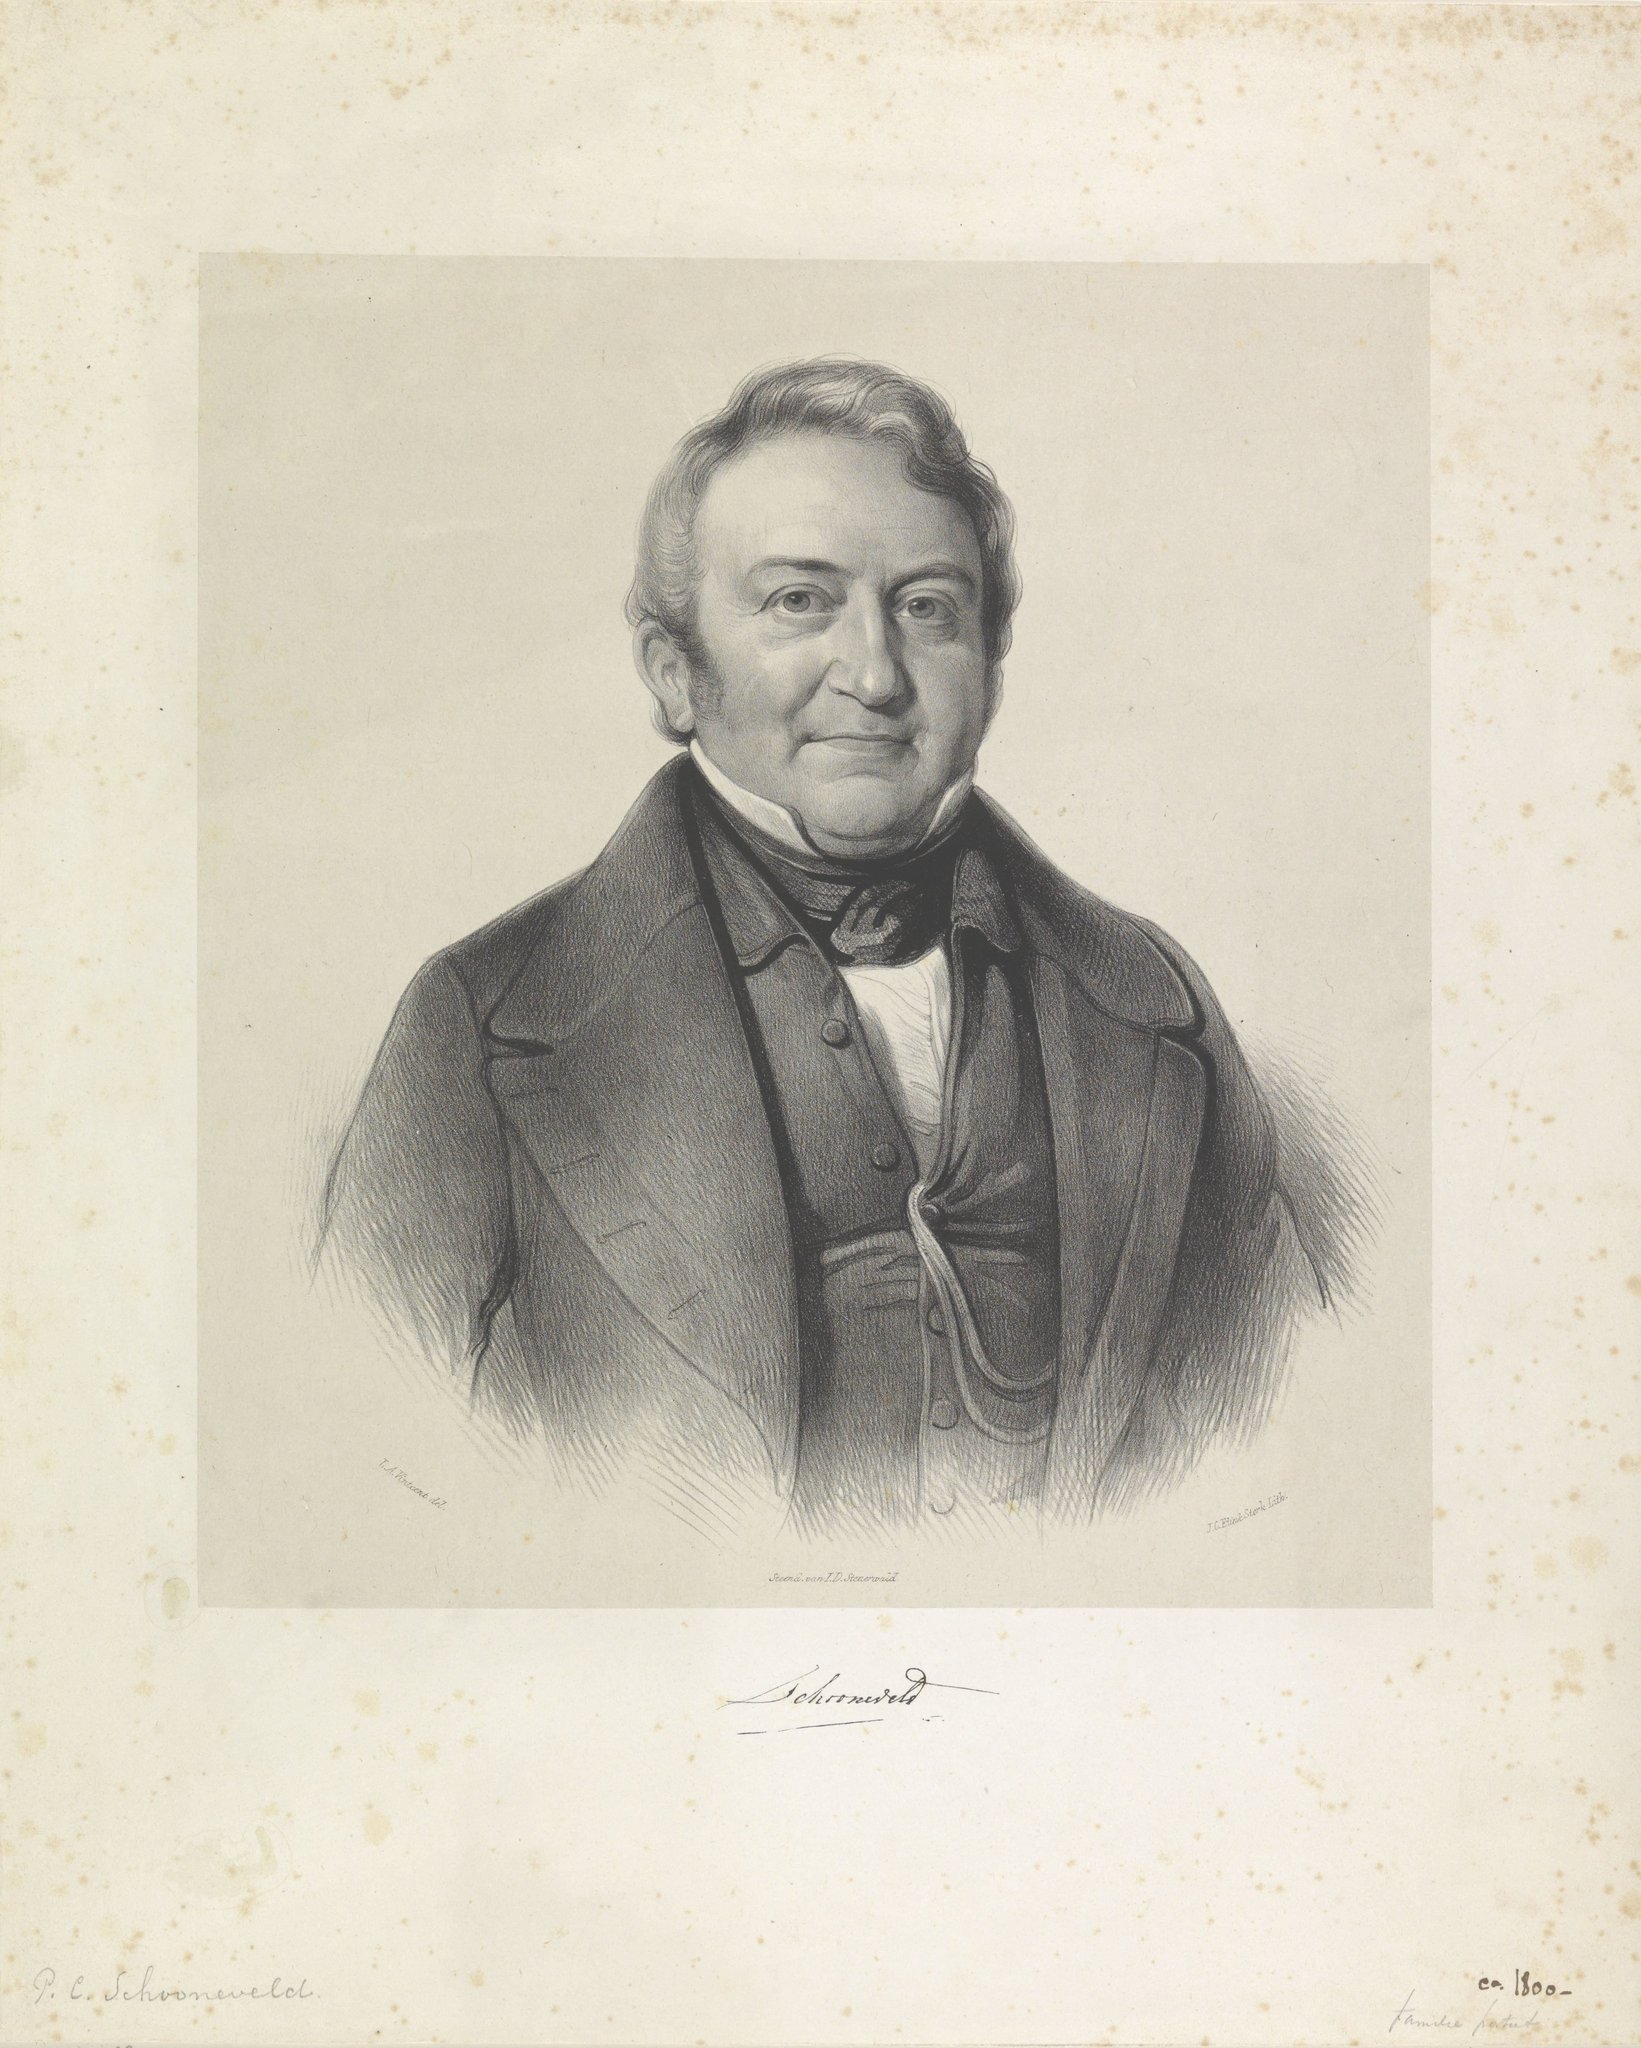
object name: print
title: Portret van Pieter Carel Schooneveld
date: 1822-1853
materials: paper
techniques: lithograph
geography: the hague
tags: amsterdam, historical persons (+ (full) bust portrait)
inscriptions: collector's mark: Lugt 2228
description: De geportretteerde draagt een open jas, opstaande kraag en gestrikte das. Aan zijn vest zit een horlogeketting of lint. Onder het portret zijn signatuur.